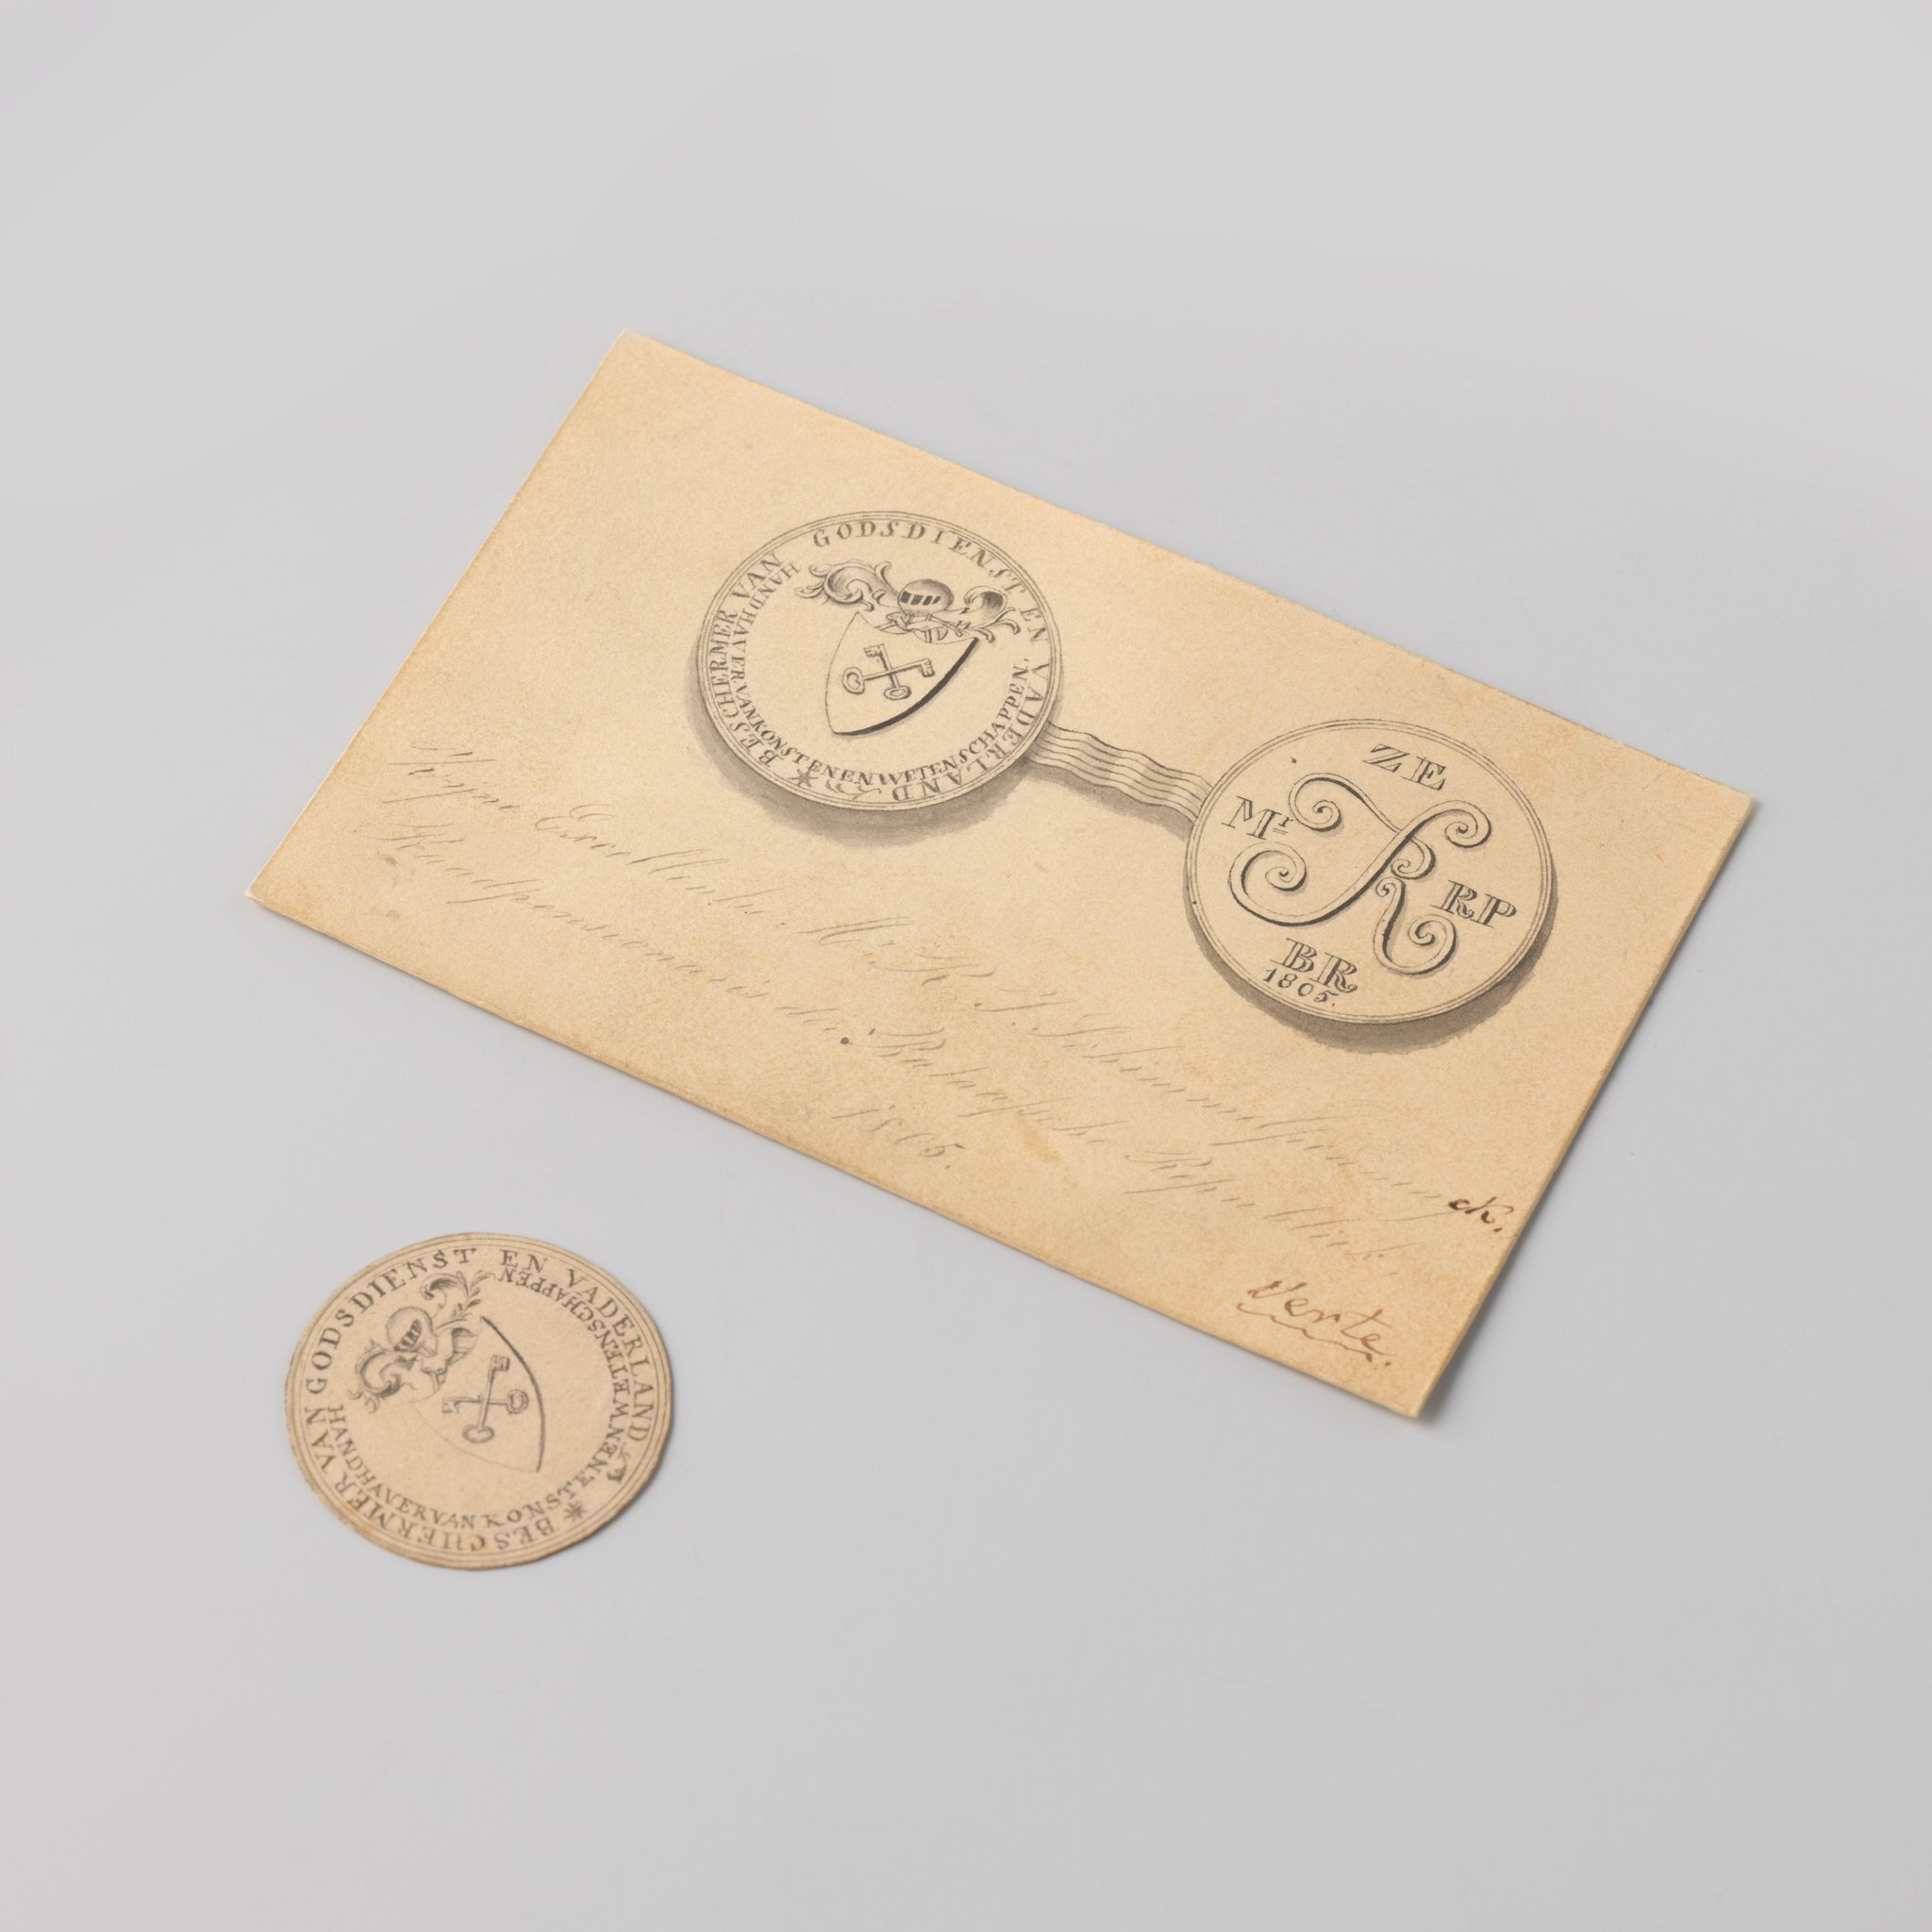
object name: drawing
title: Afbeelding van penning ter ere van mr. Rutger Jan Schimmelpenninck, raadpensionaris der Bataafse Republiek, beschermer van godsdienst en vaderland, handhaver van kunst en wetenschappen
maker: Anonymous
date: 1805-1844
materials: cardboard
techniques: painted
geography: netherlands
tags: deventer, amsterdam, rutger jan schimmelpenninck (1761-1825), batavian republic